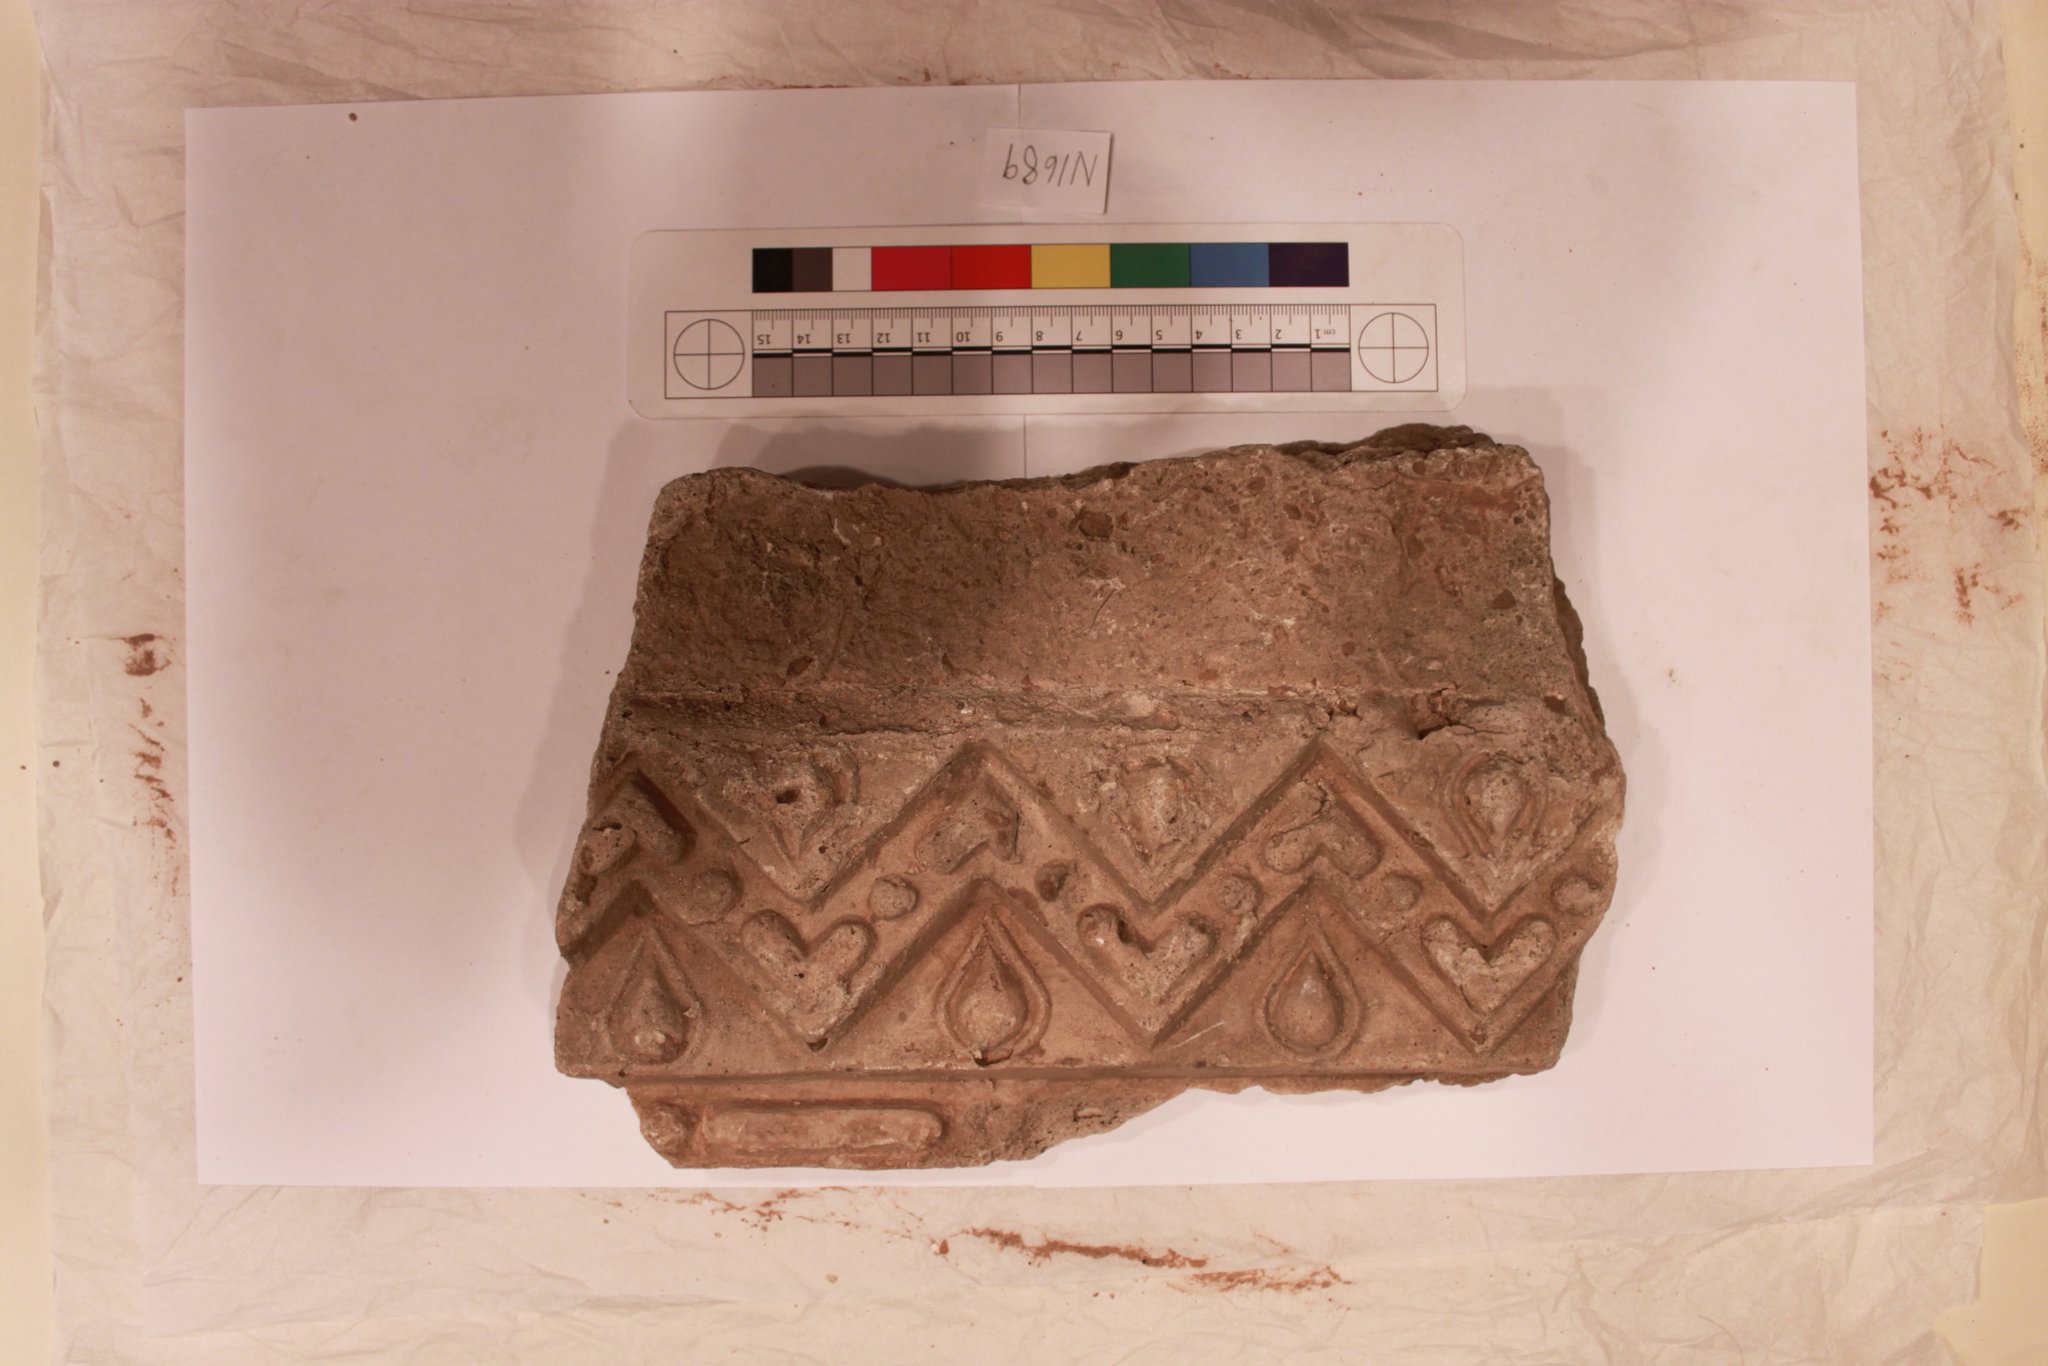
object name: fragment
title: Stucco Fragment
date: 701-1200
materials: plaster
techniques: carving, painting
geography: iran